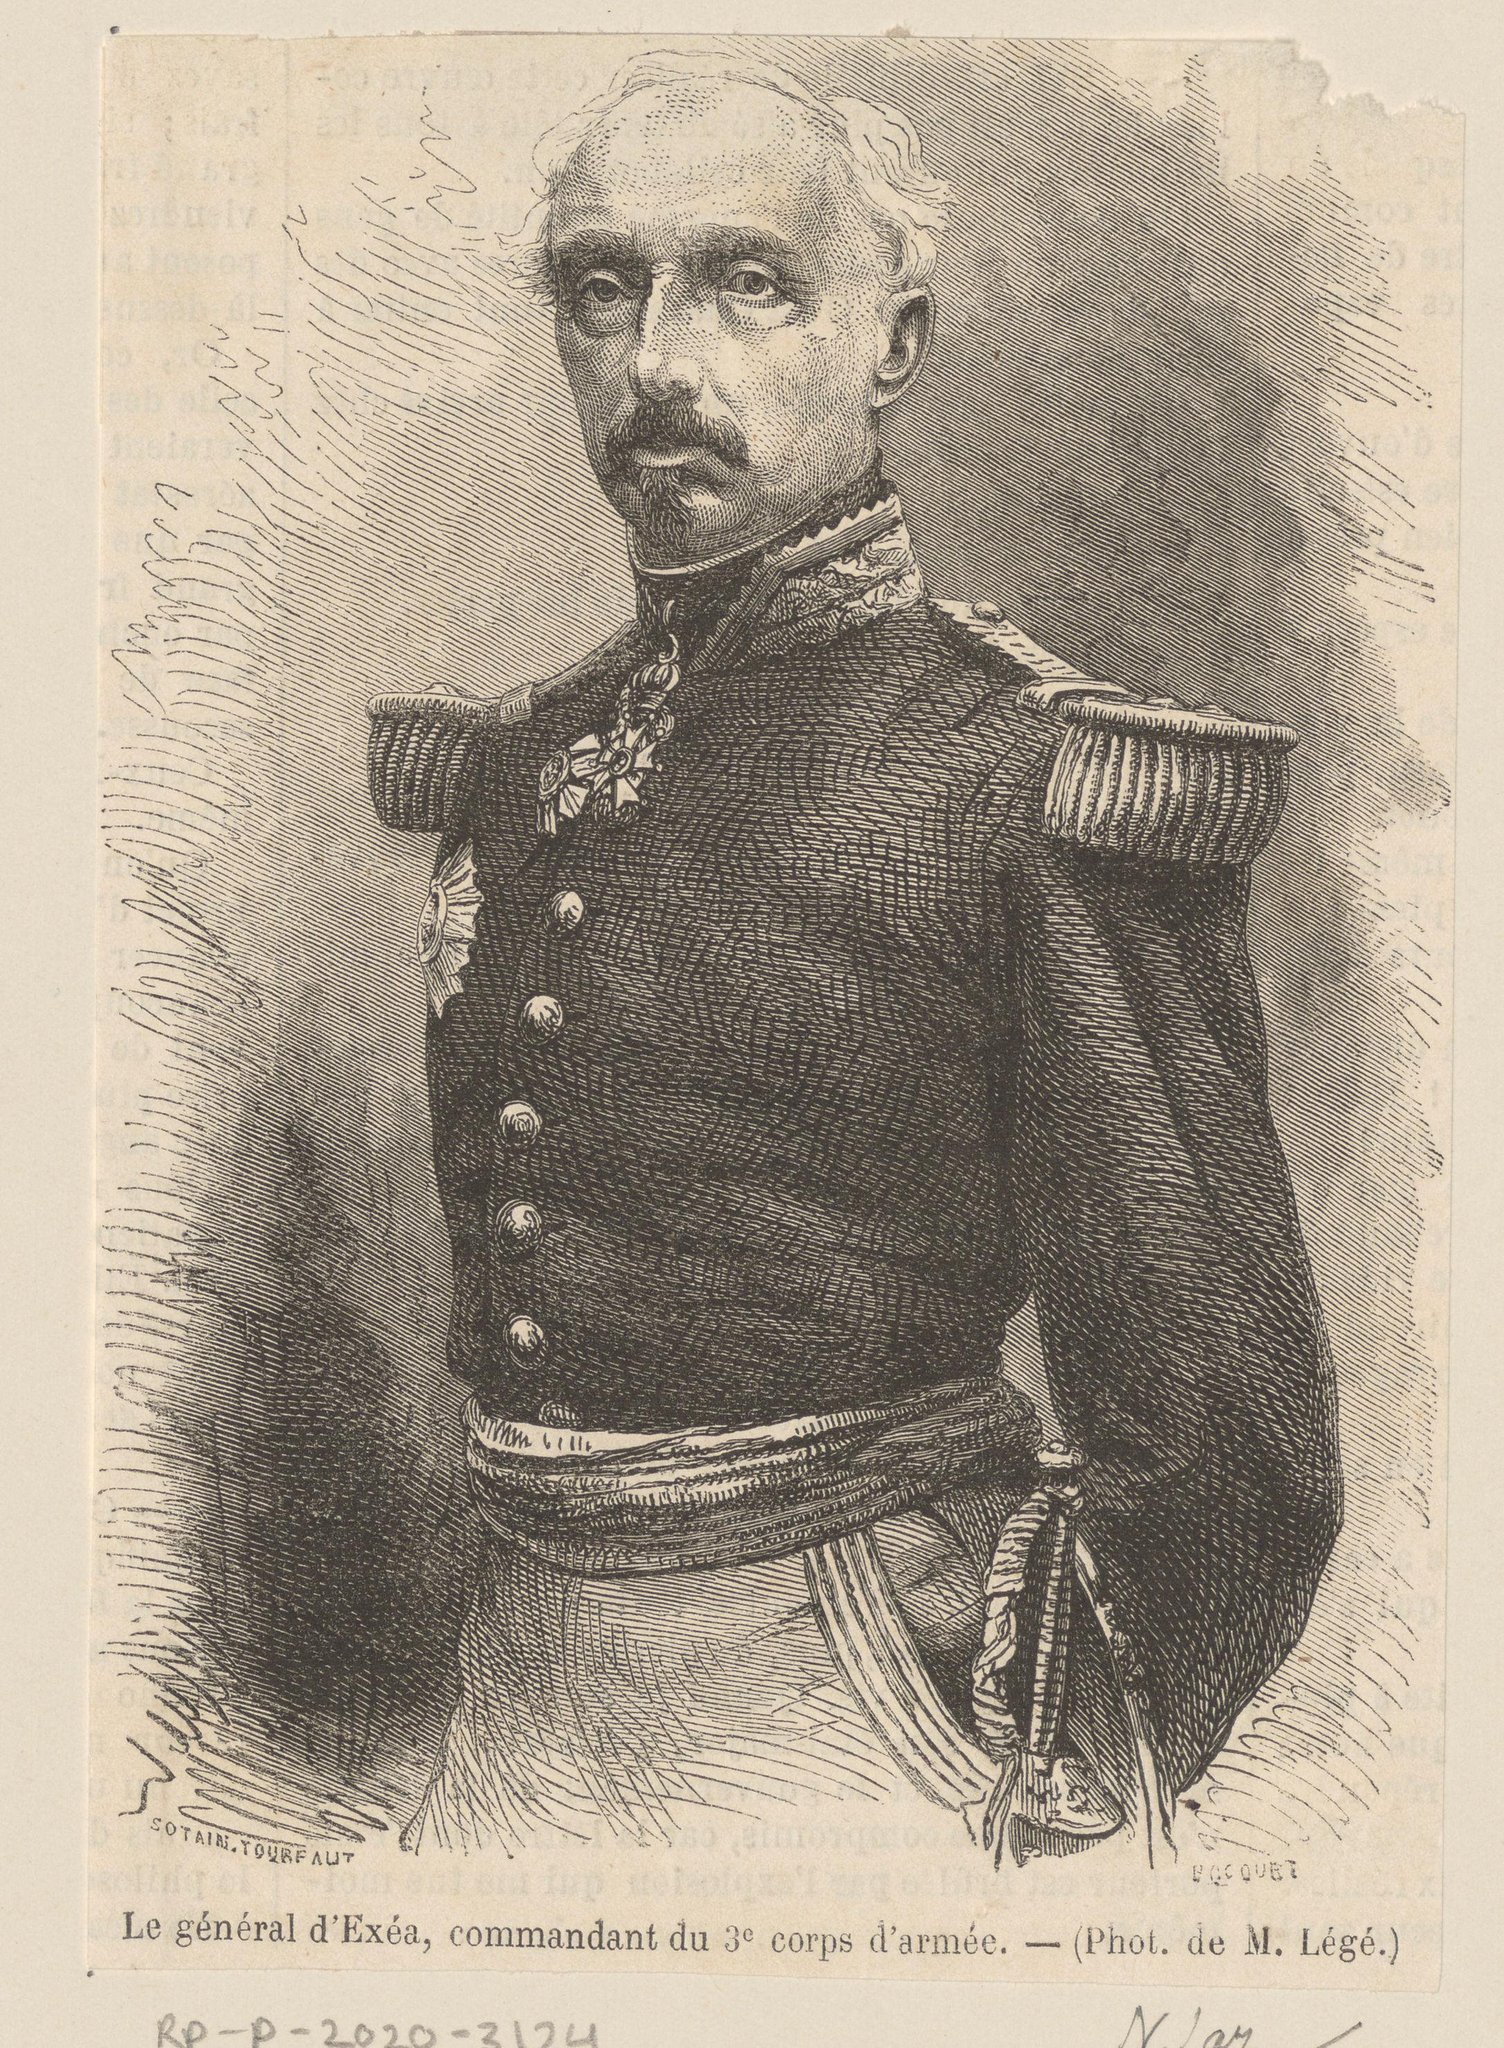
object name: print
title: Portret van Antoine-Achille d'Exéa-Doumerc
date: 1870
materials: paper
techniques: letterpress printing, engraving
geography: france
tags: commander-in-chief, general, marshal, historical persons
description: Prent uit: Le Monde Illustré 14 (1870), nr. 710, 19 november 1870.